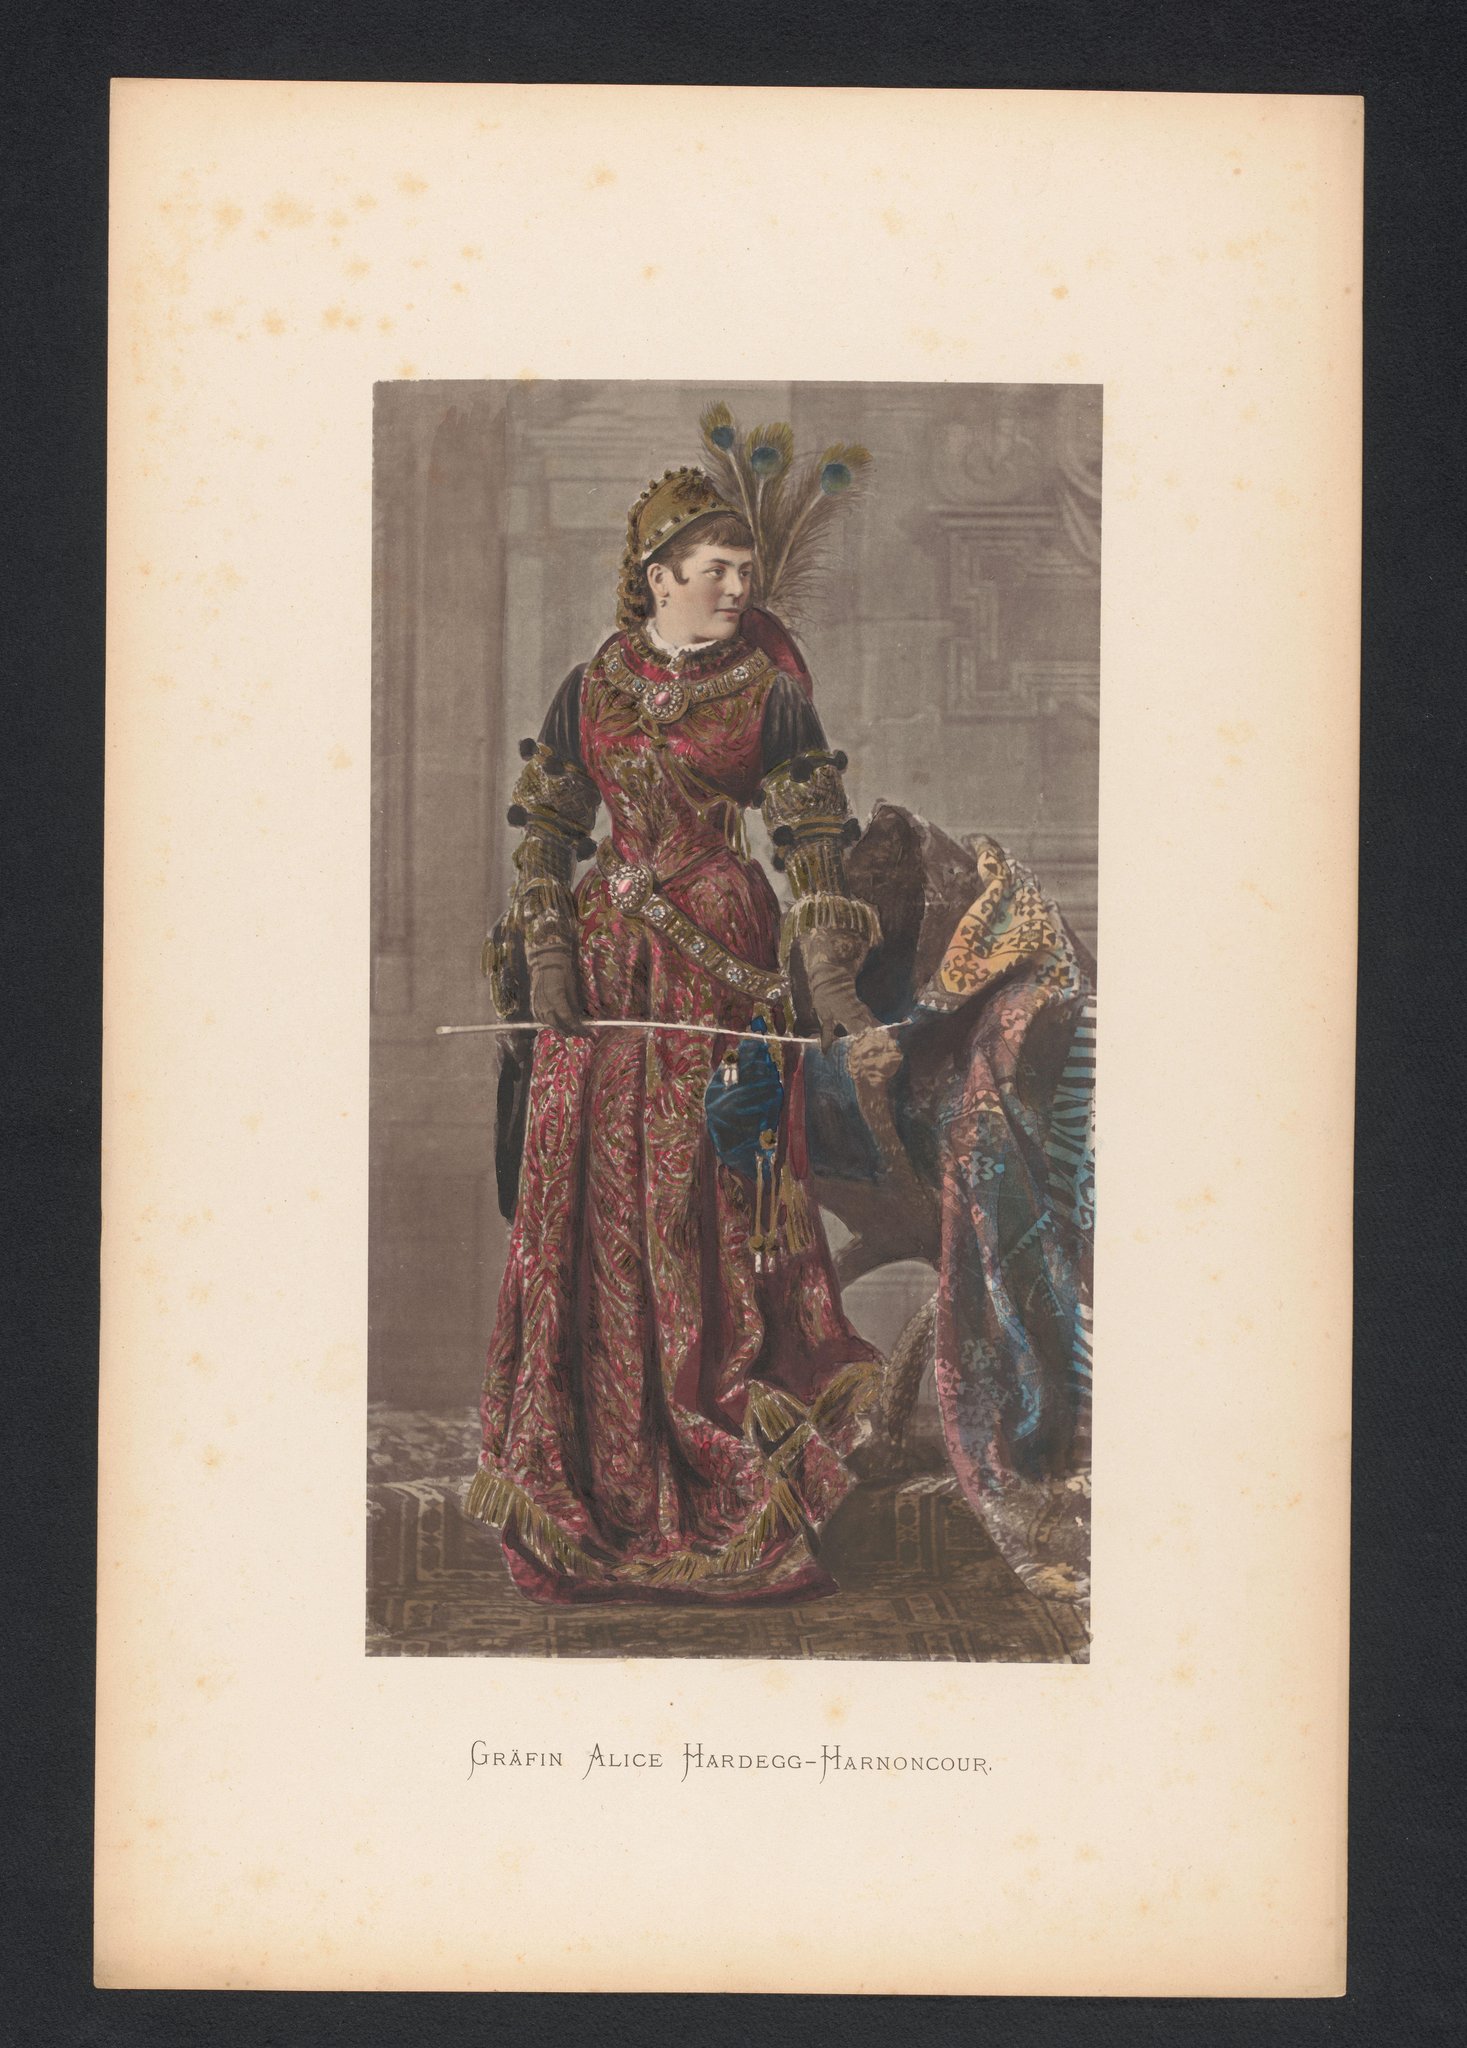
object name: photomechanical print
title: Gräfin Alice Hardegg-Harnoncour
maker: Anonymous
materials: paper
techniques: photograph, hand coloring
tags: historical persons - bb - woman, aristocracy; 'aristocratia' (ripa)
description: Deze prent maakt deel uit van een omslag met 86 prenten op 78 bladen en 11 tekstbladen.